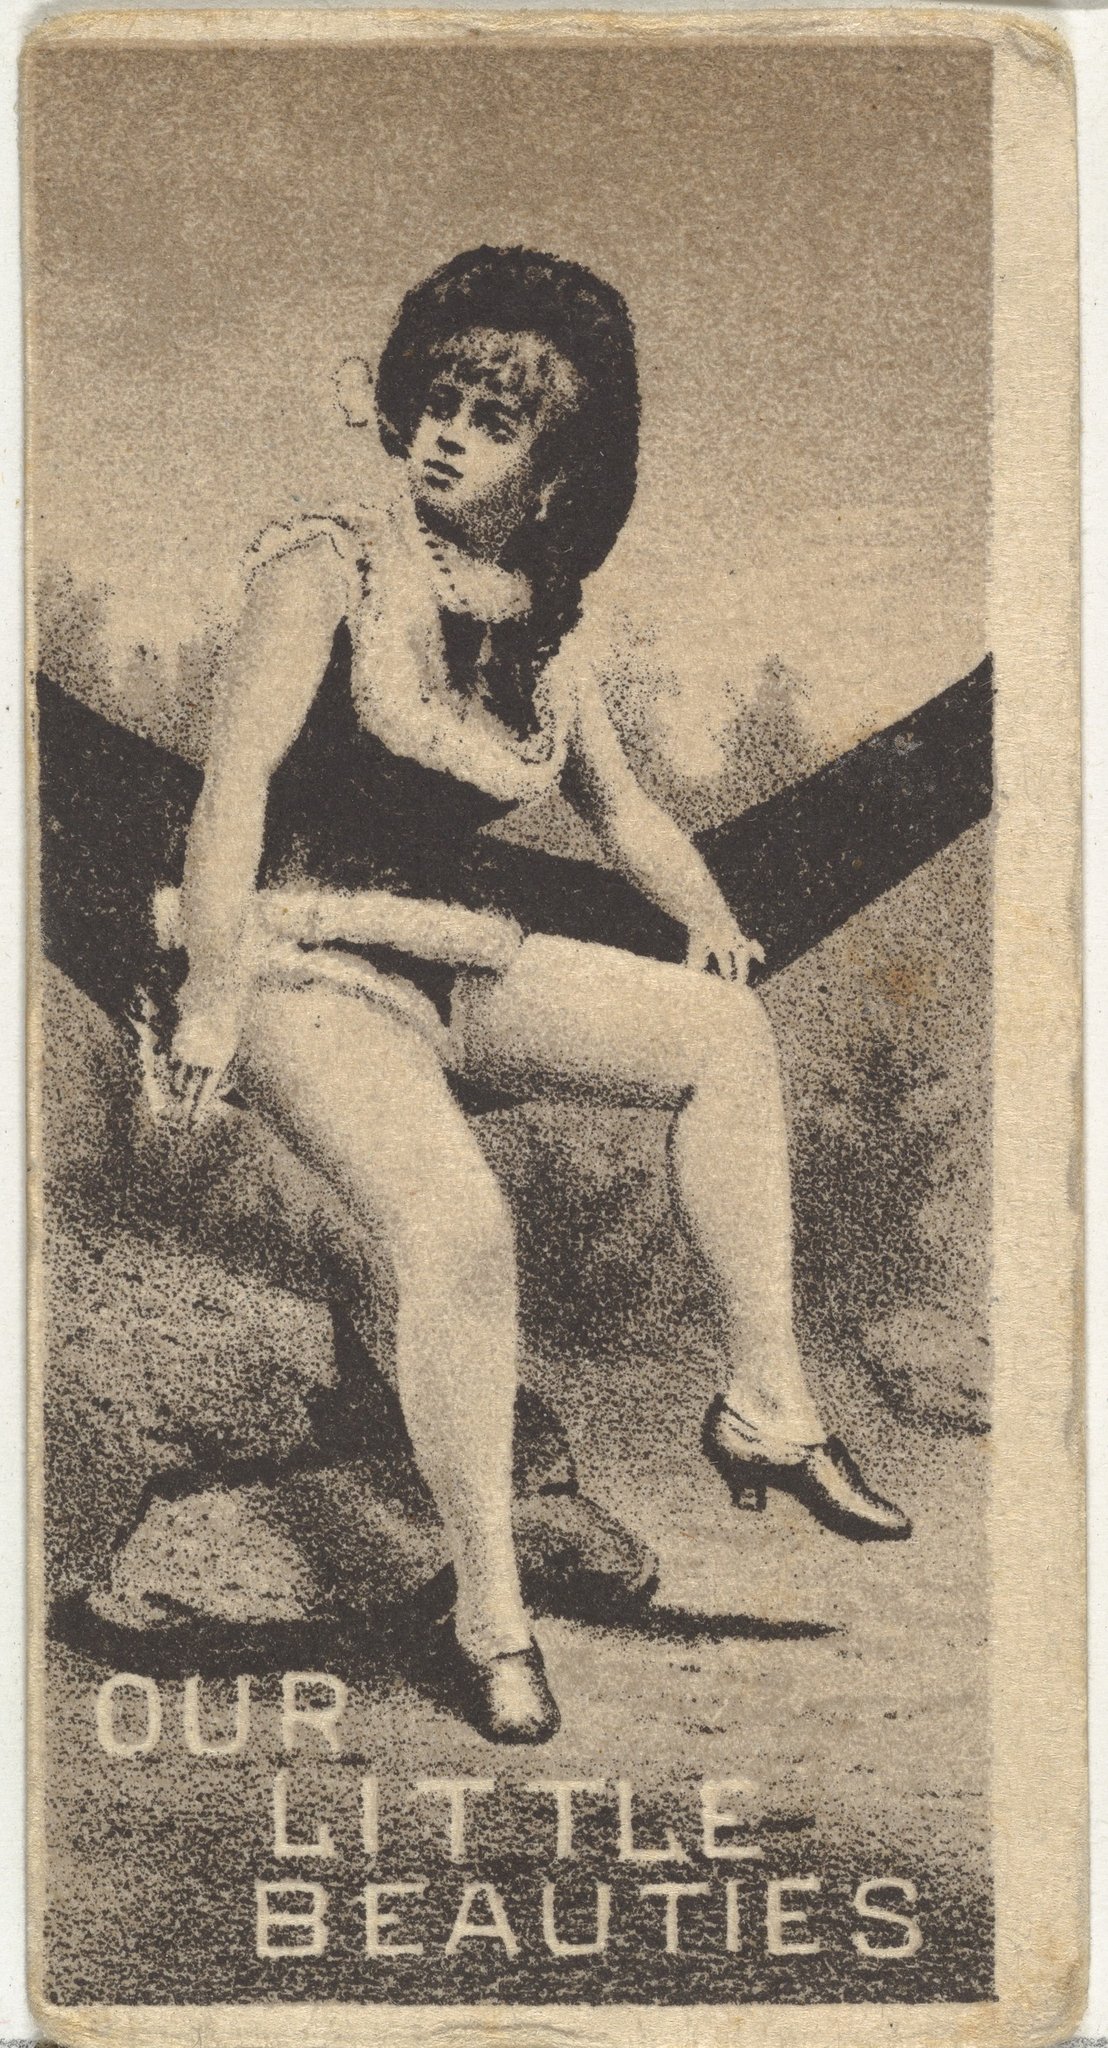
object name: print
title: From the Actresses series (N57) promoting Our Little Beauties Cigarettes for Allen & Ginter brand tobacco products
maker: allen & ginter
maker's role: publisher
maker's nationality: american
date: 1890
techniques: photolithograph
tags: women,actresses